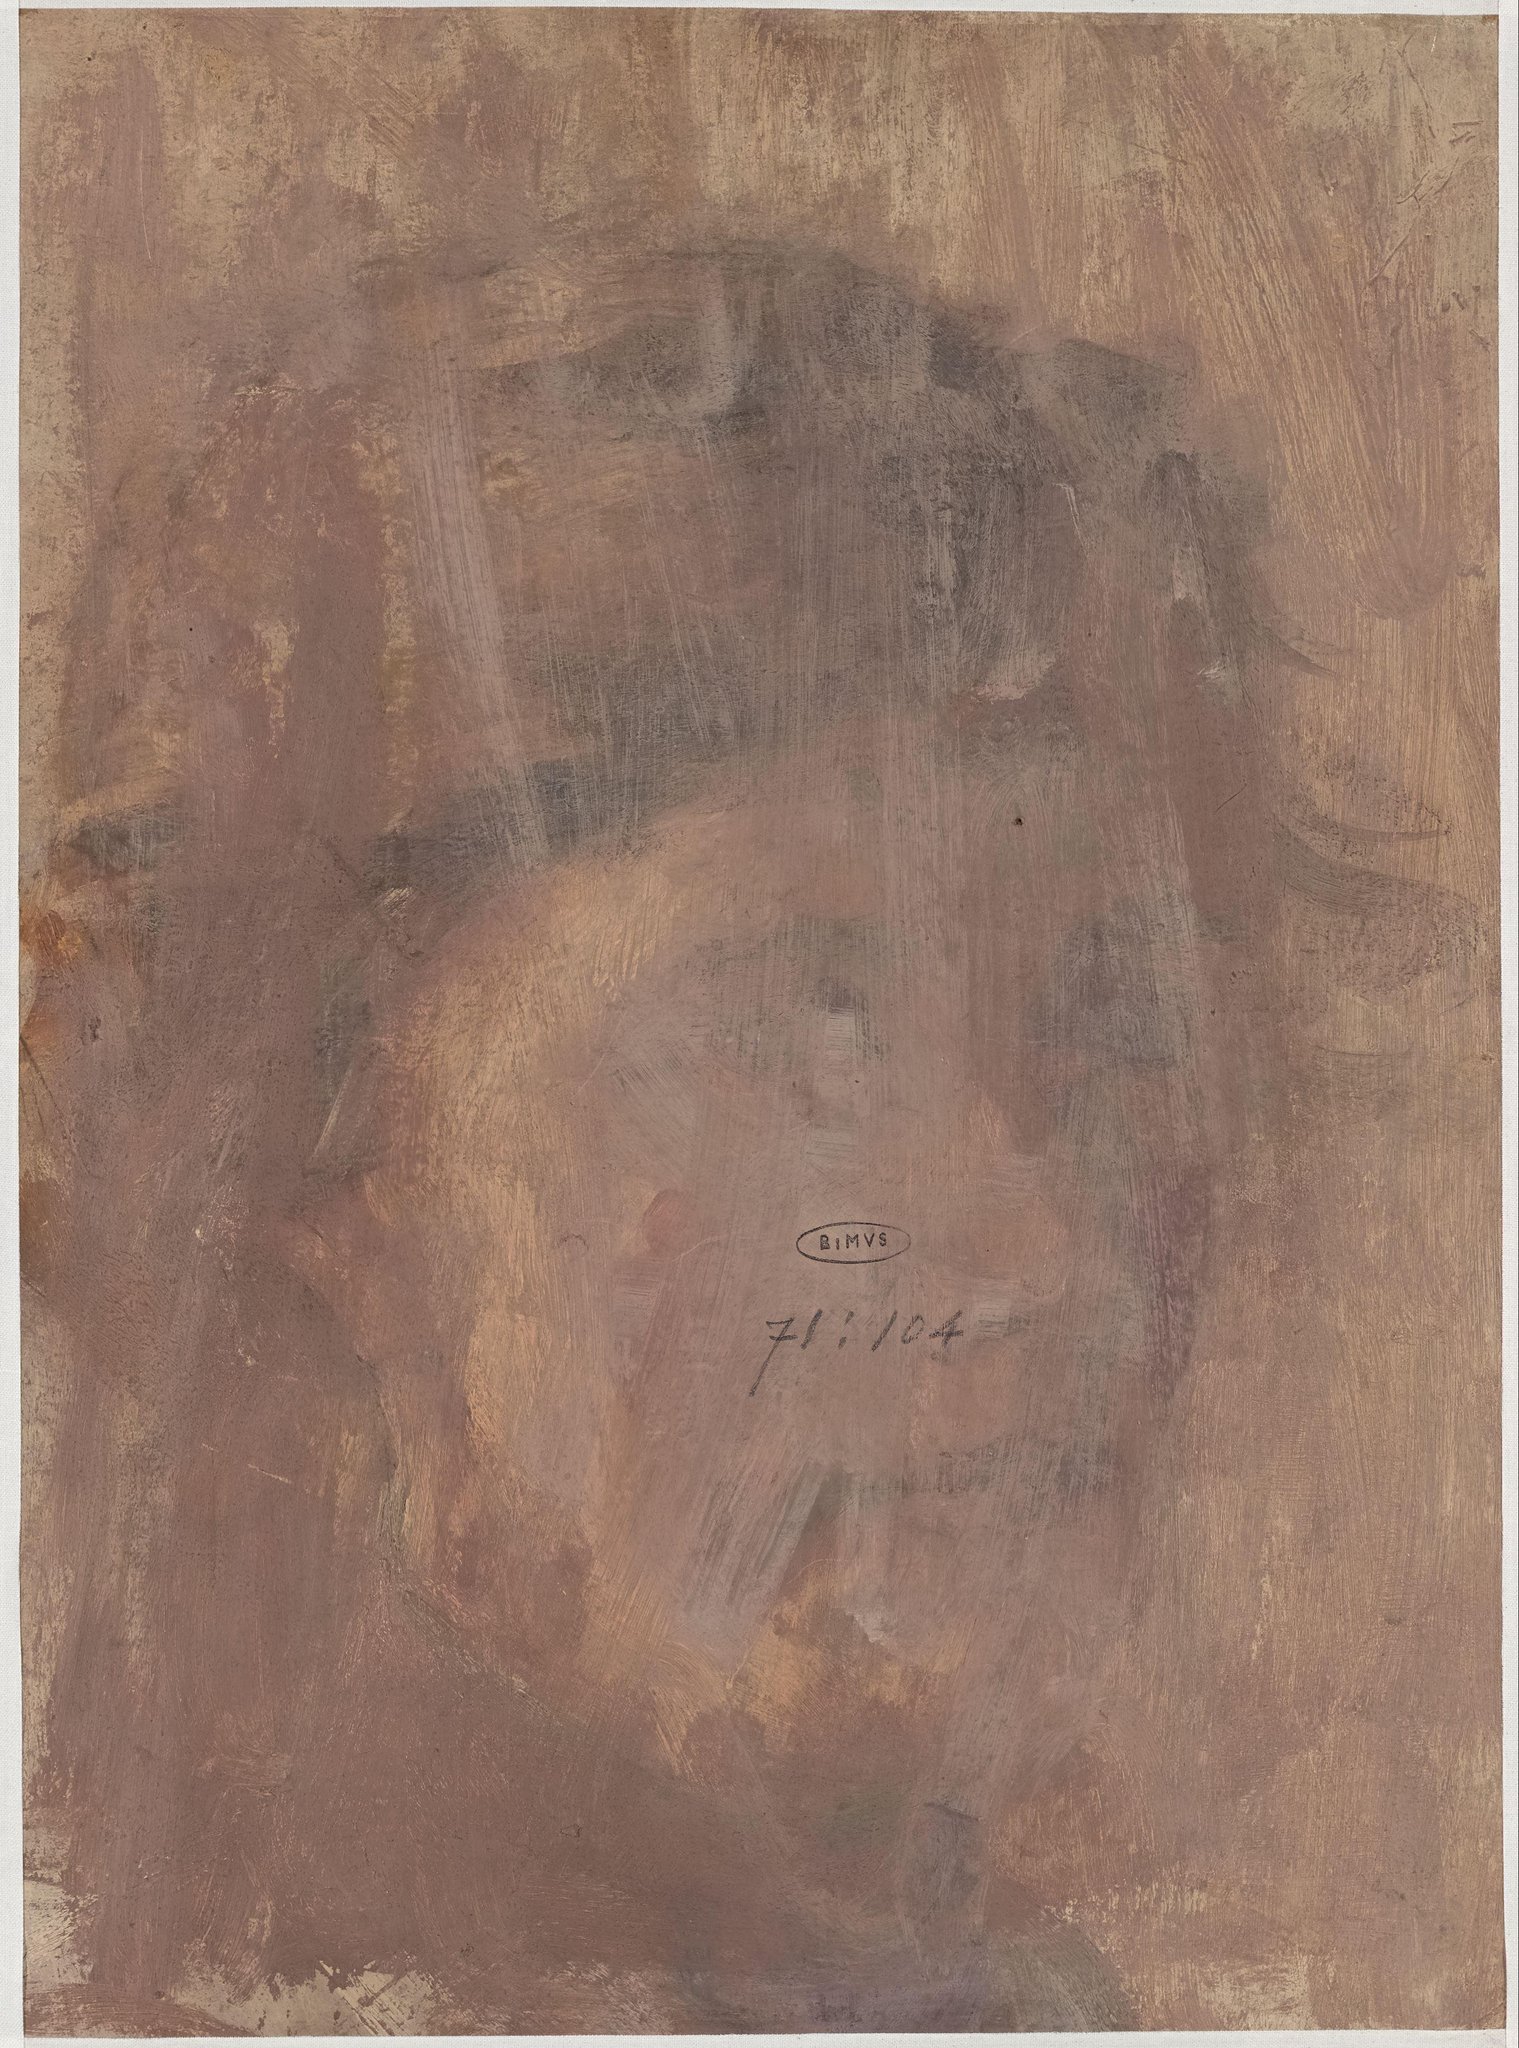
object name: drawing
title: Portret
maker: lucie van dam van isselt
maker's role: draughtsman, print maker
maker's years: 1871-1949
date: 1914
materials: cardboard, oil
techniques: brush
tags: anonymous historical person portrayed alone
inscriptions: date